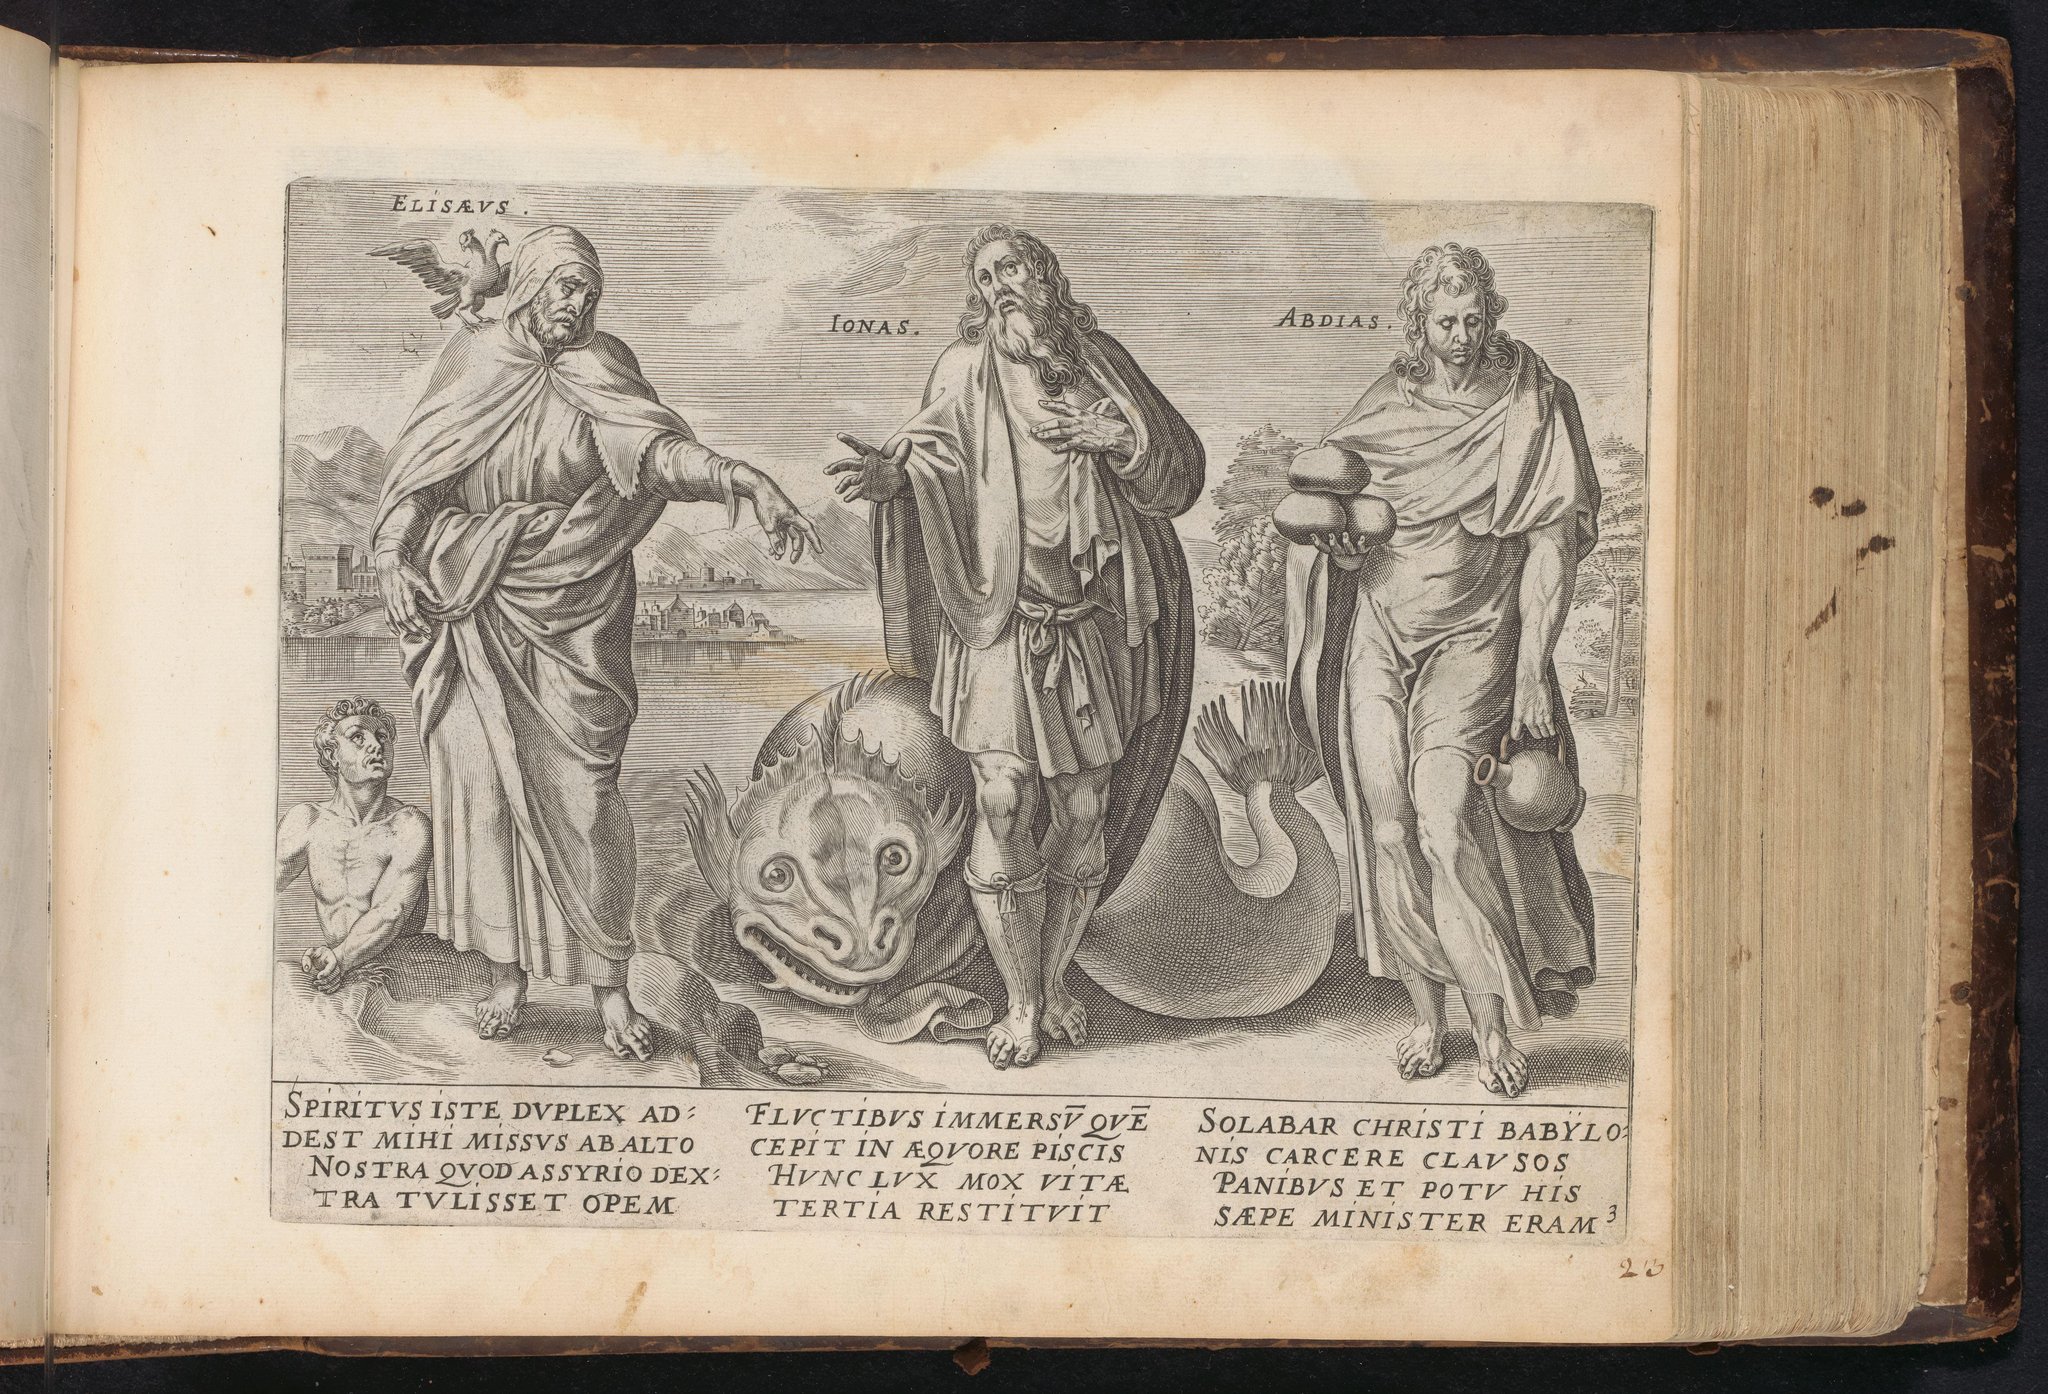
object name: album leaf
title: Den Grooten Figuer-Bibel (...)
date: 1579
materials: paper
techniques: engraving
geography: amsterdam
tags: story of elisha (eliseus), the book of jonah, the four major prophets (not in biblical context): isaiah, jeremiah, ezekiel, daniel, the book of obadiah, naaman comes to the jordan, dips himself seven times and is cured, swimming mammals: whale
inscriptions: number: ‘23[5]’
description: De profeten Elisa, Jona en Obadja staan naast elkaar in een landschap. Elisa heeft een tweekoppige vogel op de schouder staan en staat naast Naäman, die op Elisa's advies zich baadt in de Jordaan. Jona staat naast de vis, Obadja heeft drie broden en een kruik in zijn handen. Onder de voorstelling toelichtingen in het Latijn. Deze prent maakt deel uit van een album.